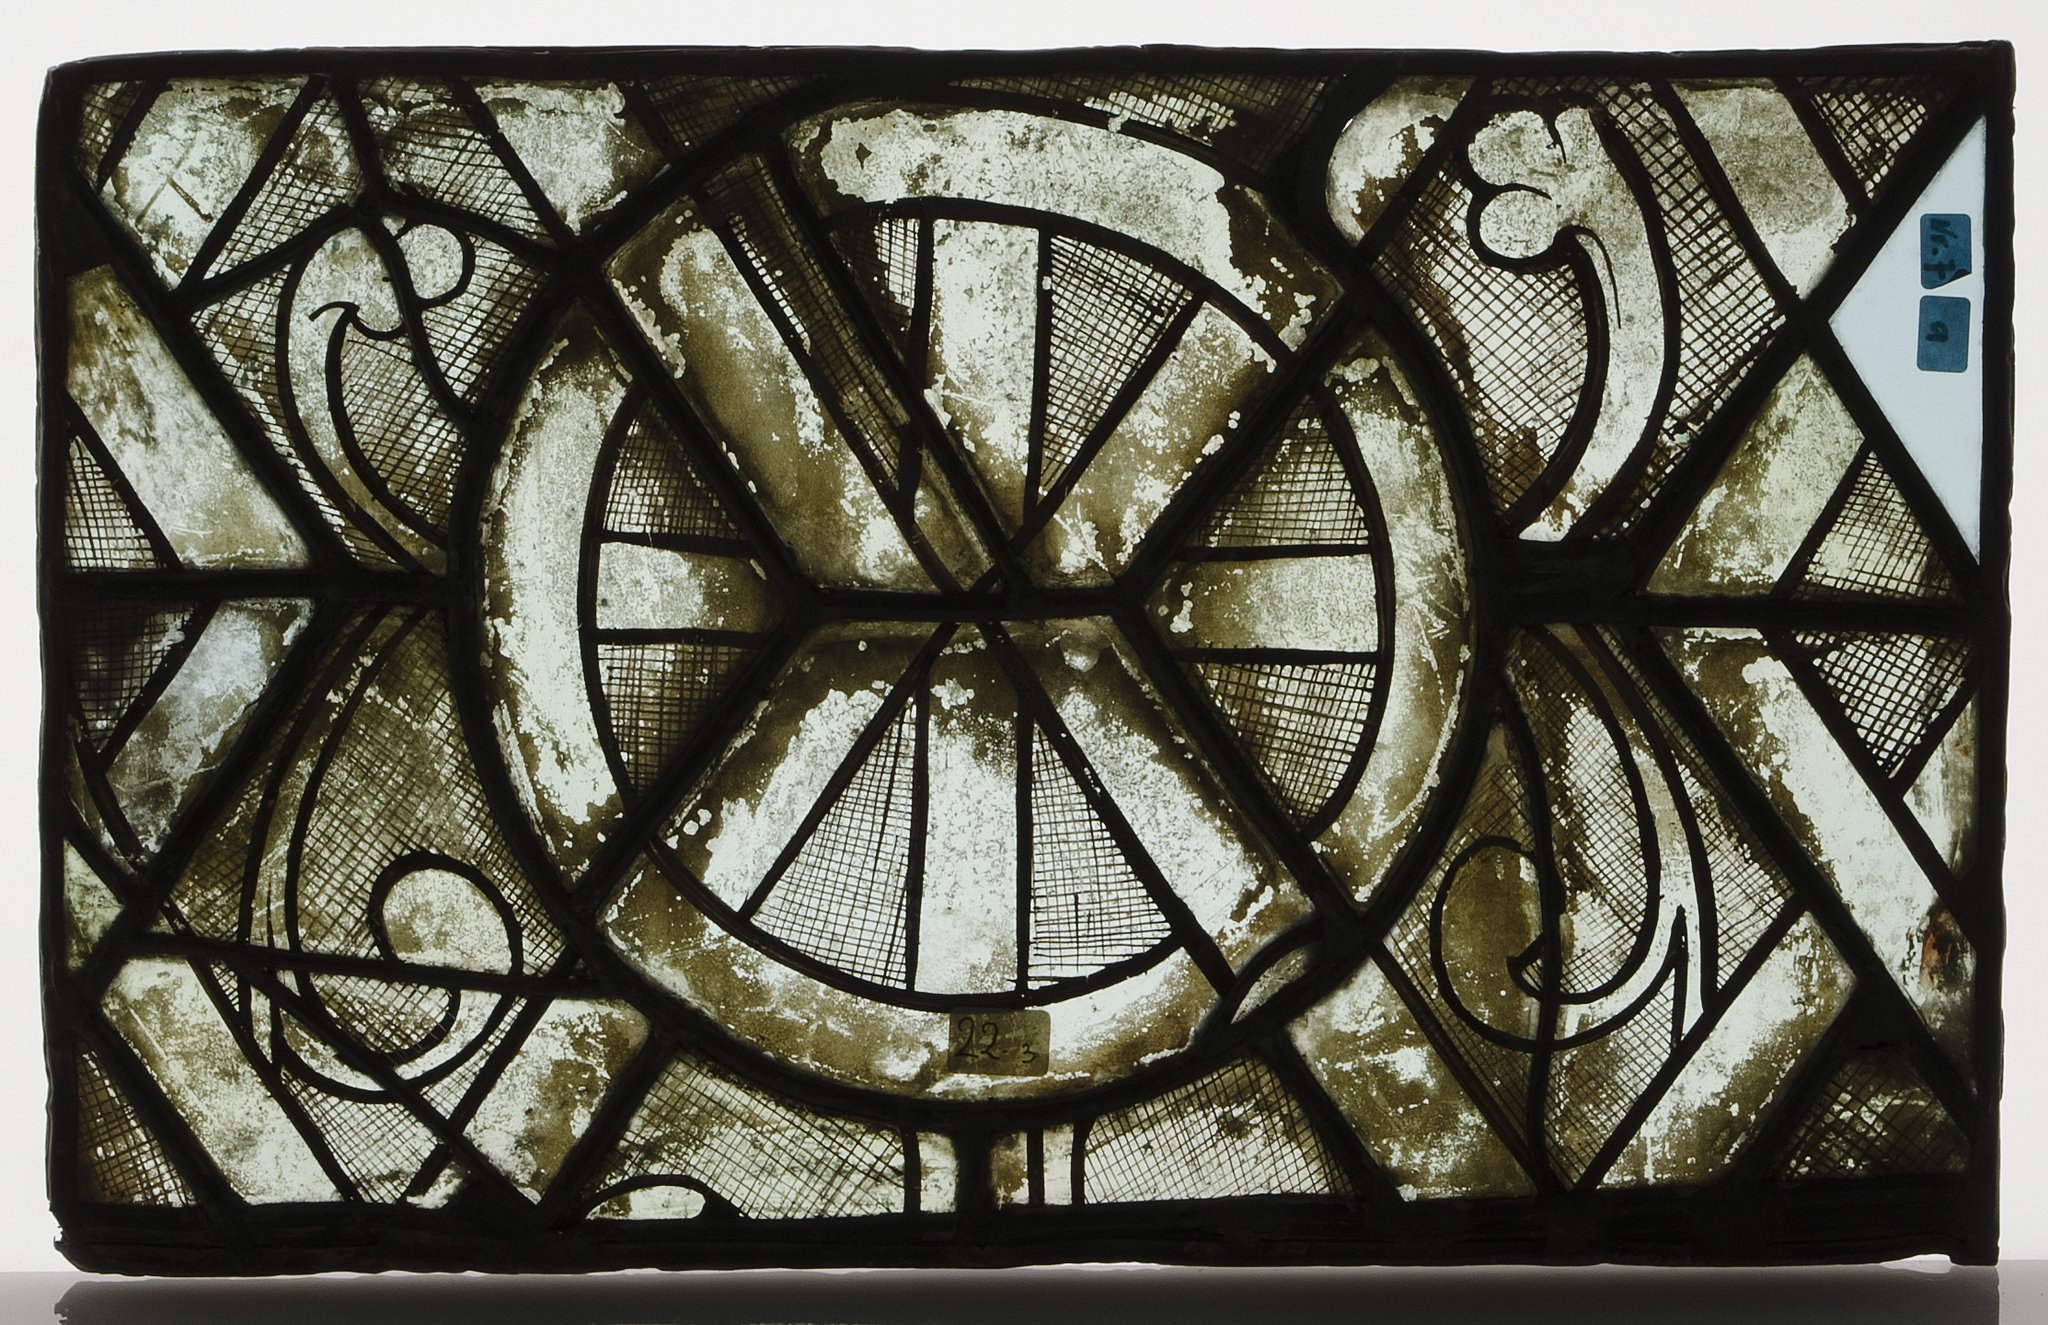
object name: panel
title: Grisalle Glass Panel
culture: french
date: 1260-1270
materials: glass, paint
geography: france